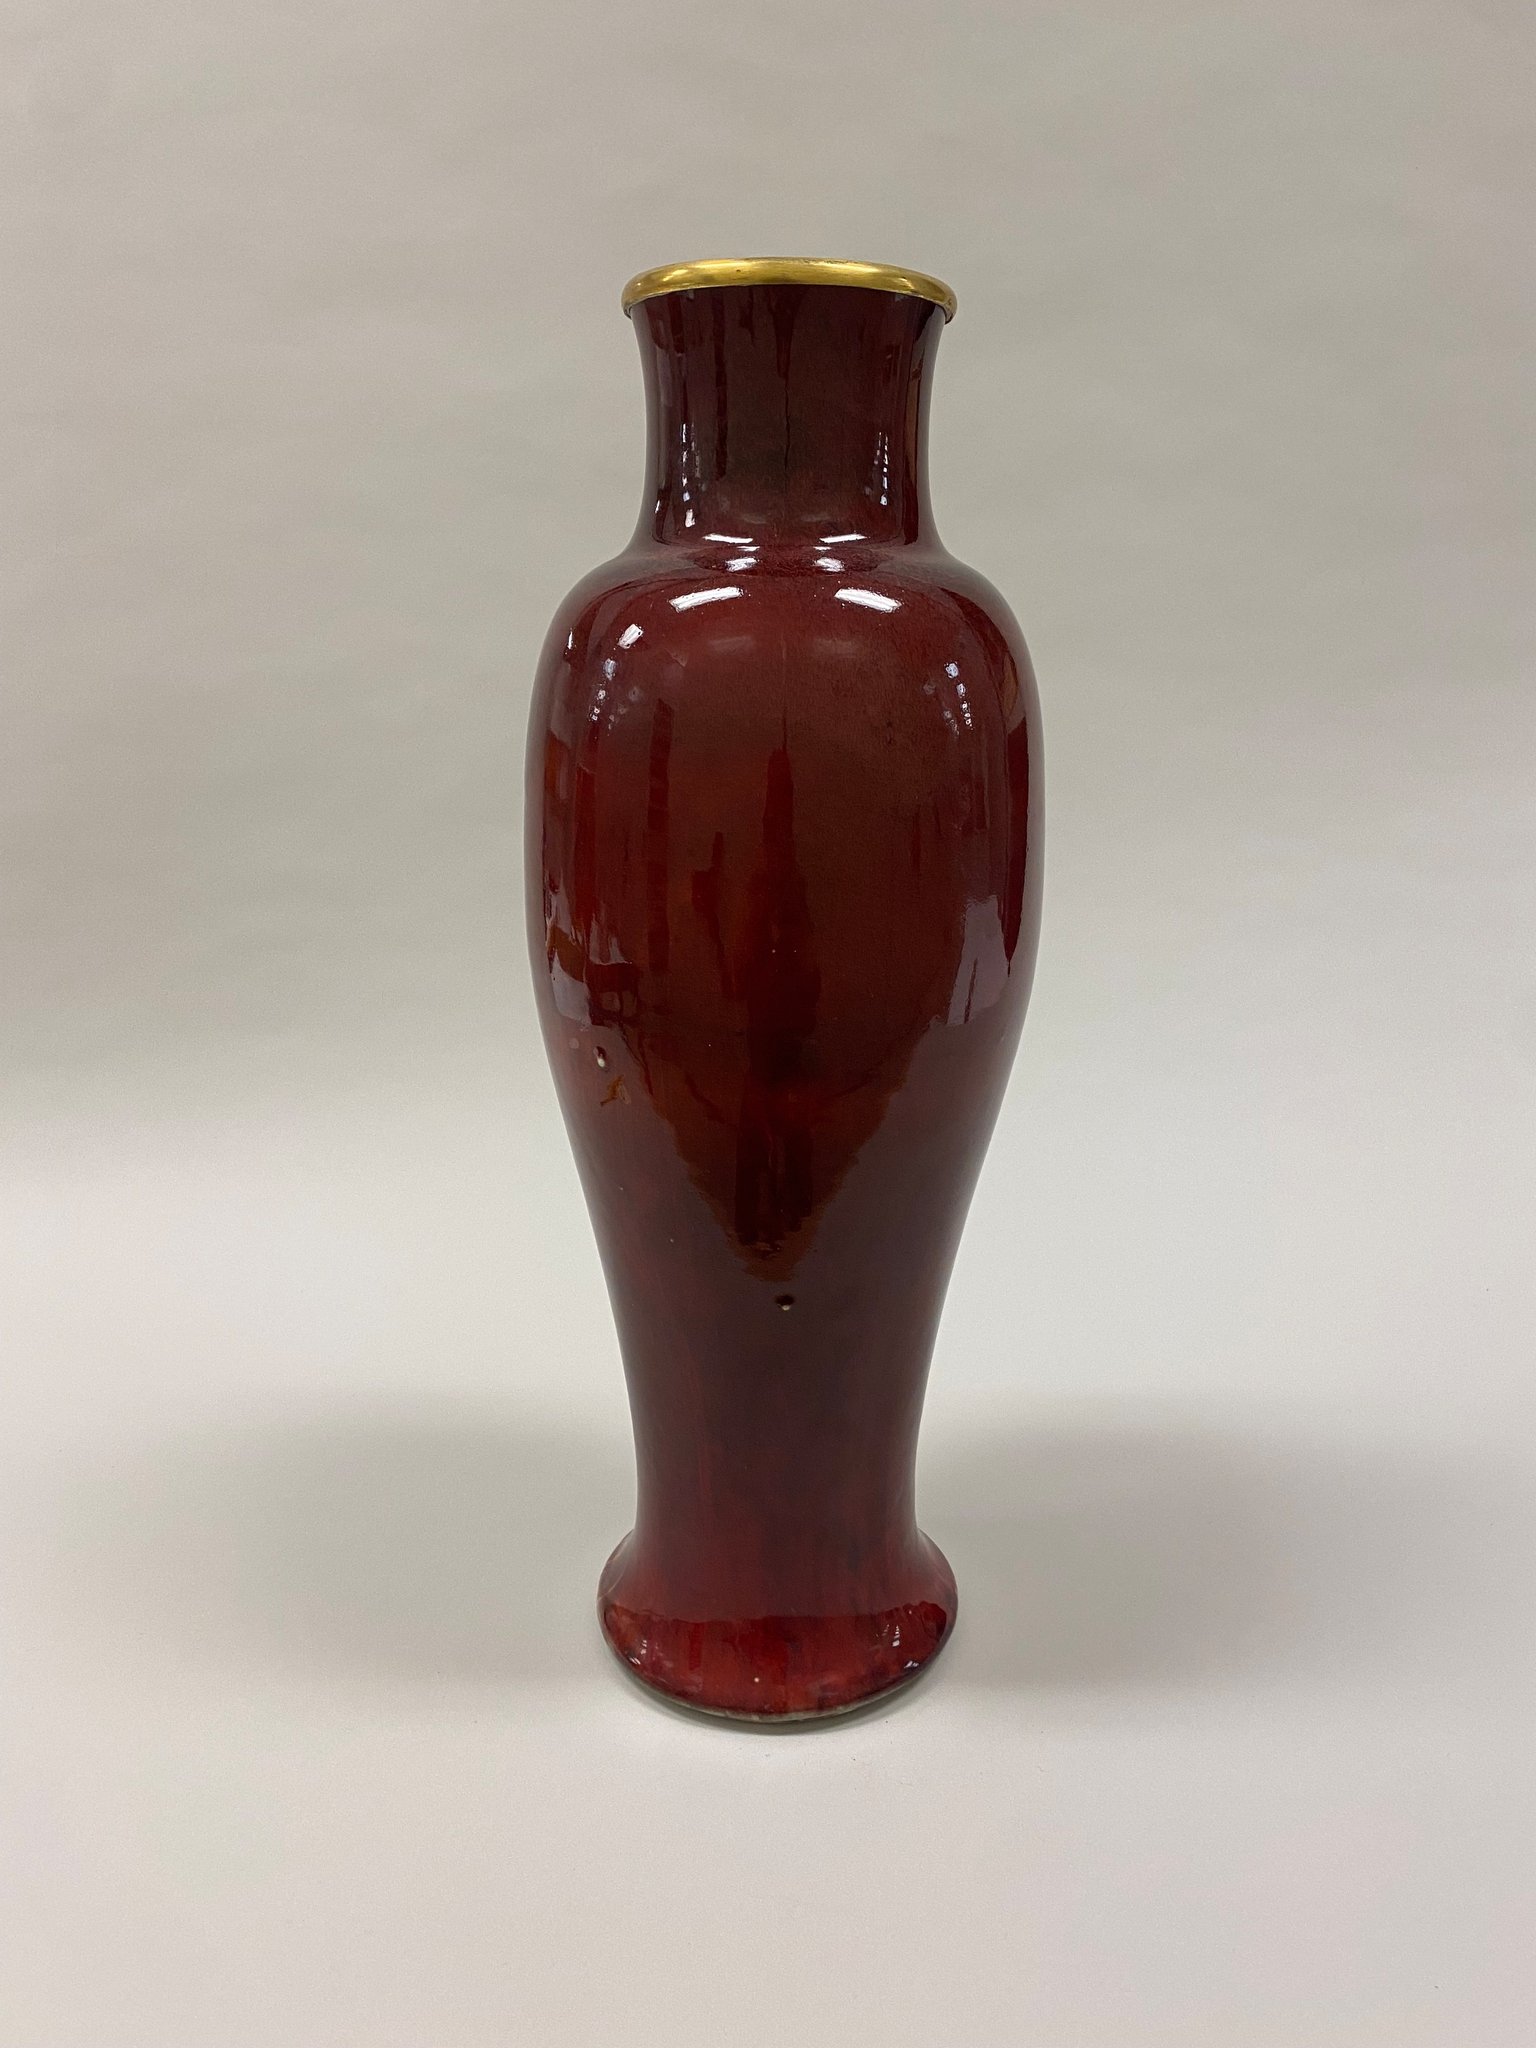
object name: vase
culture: chinese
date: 1667-1733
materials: gilt bronze, glaze, porcelain